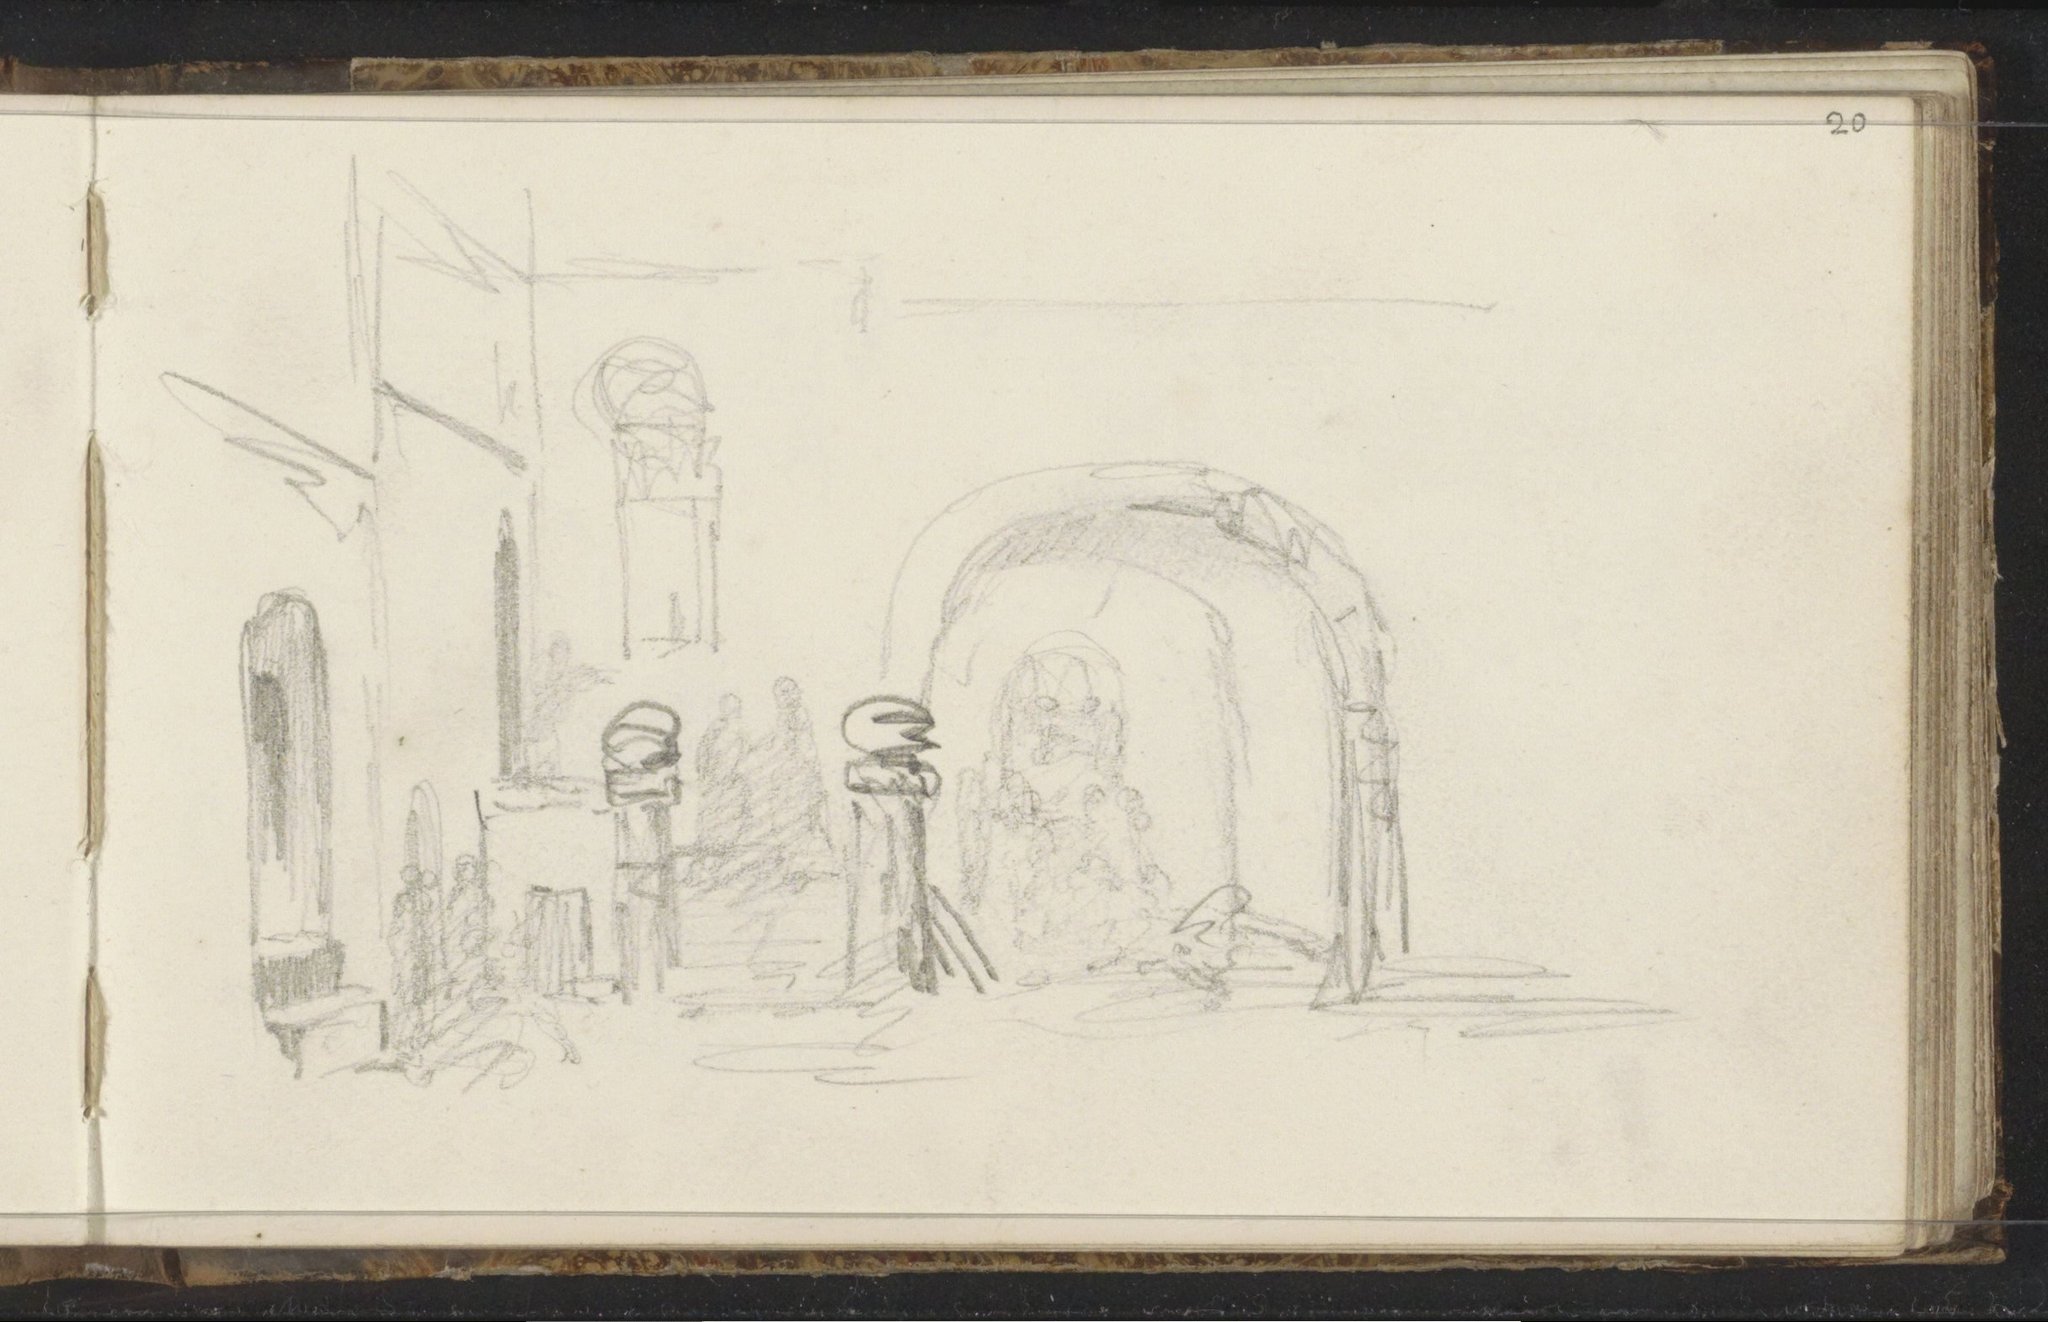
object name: sketchbook leaf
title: Straat of binnenplaats met poort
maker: willem hendrik schmidt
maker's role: draughtsman, painter, print maker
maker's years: 1809-1849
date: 1819-1849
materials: paper, pencil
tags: gate, entrance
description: Blad 20 recto uit een schetsboek met 60 bladen.